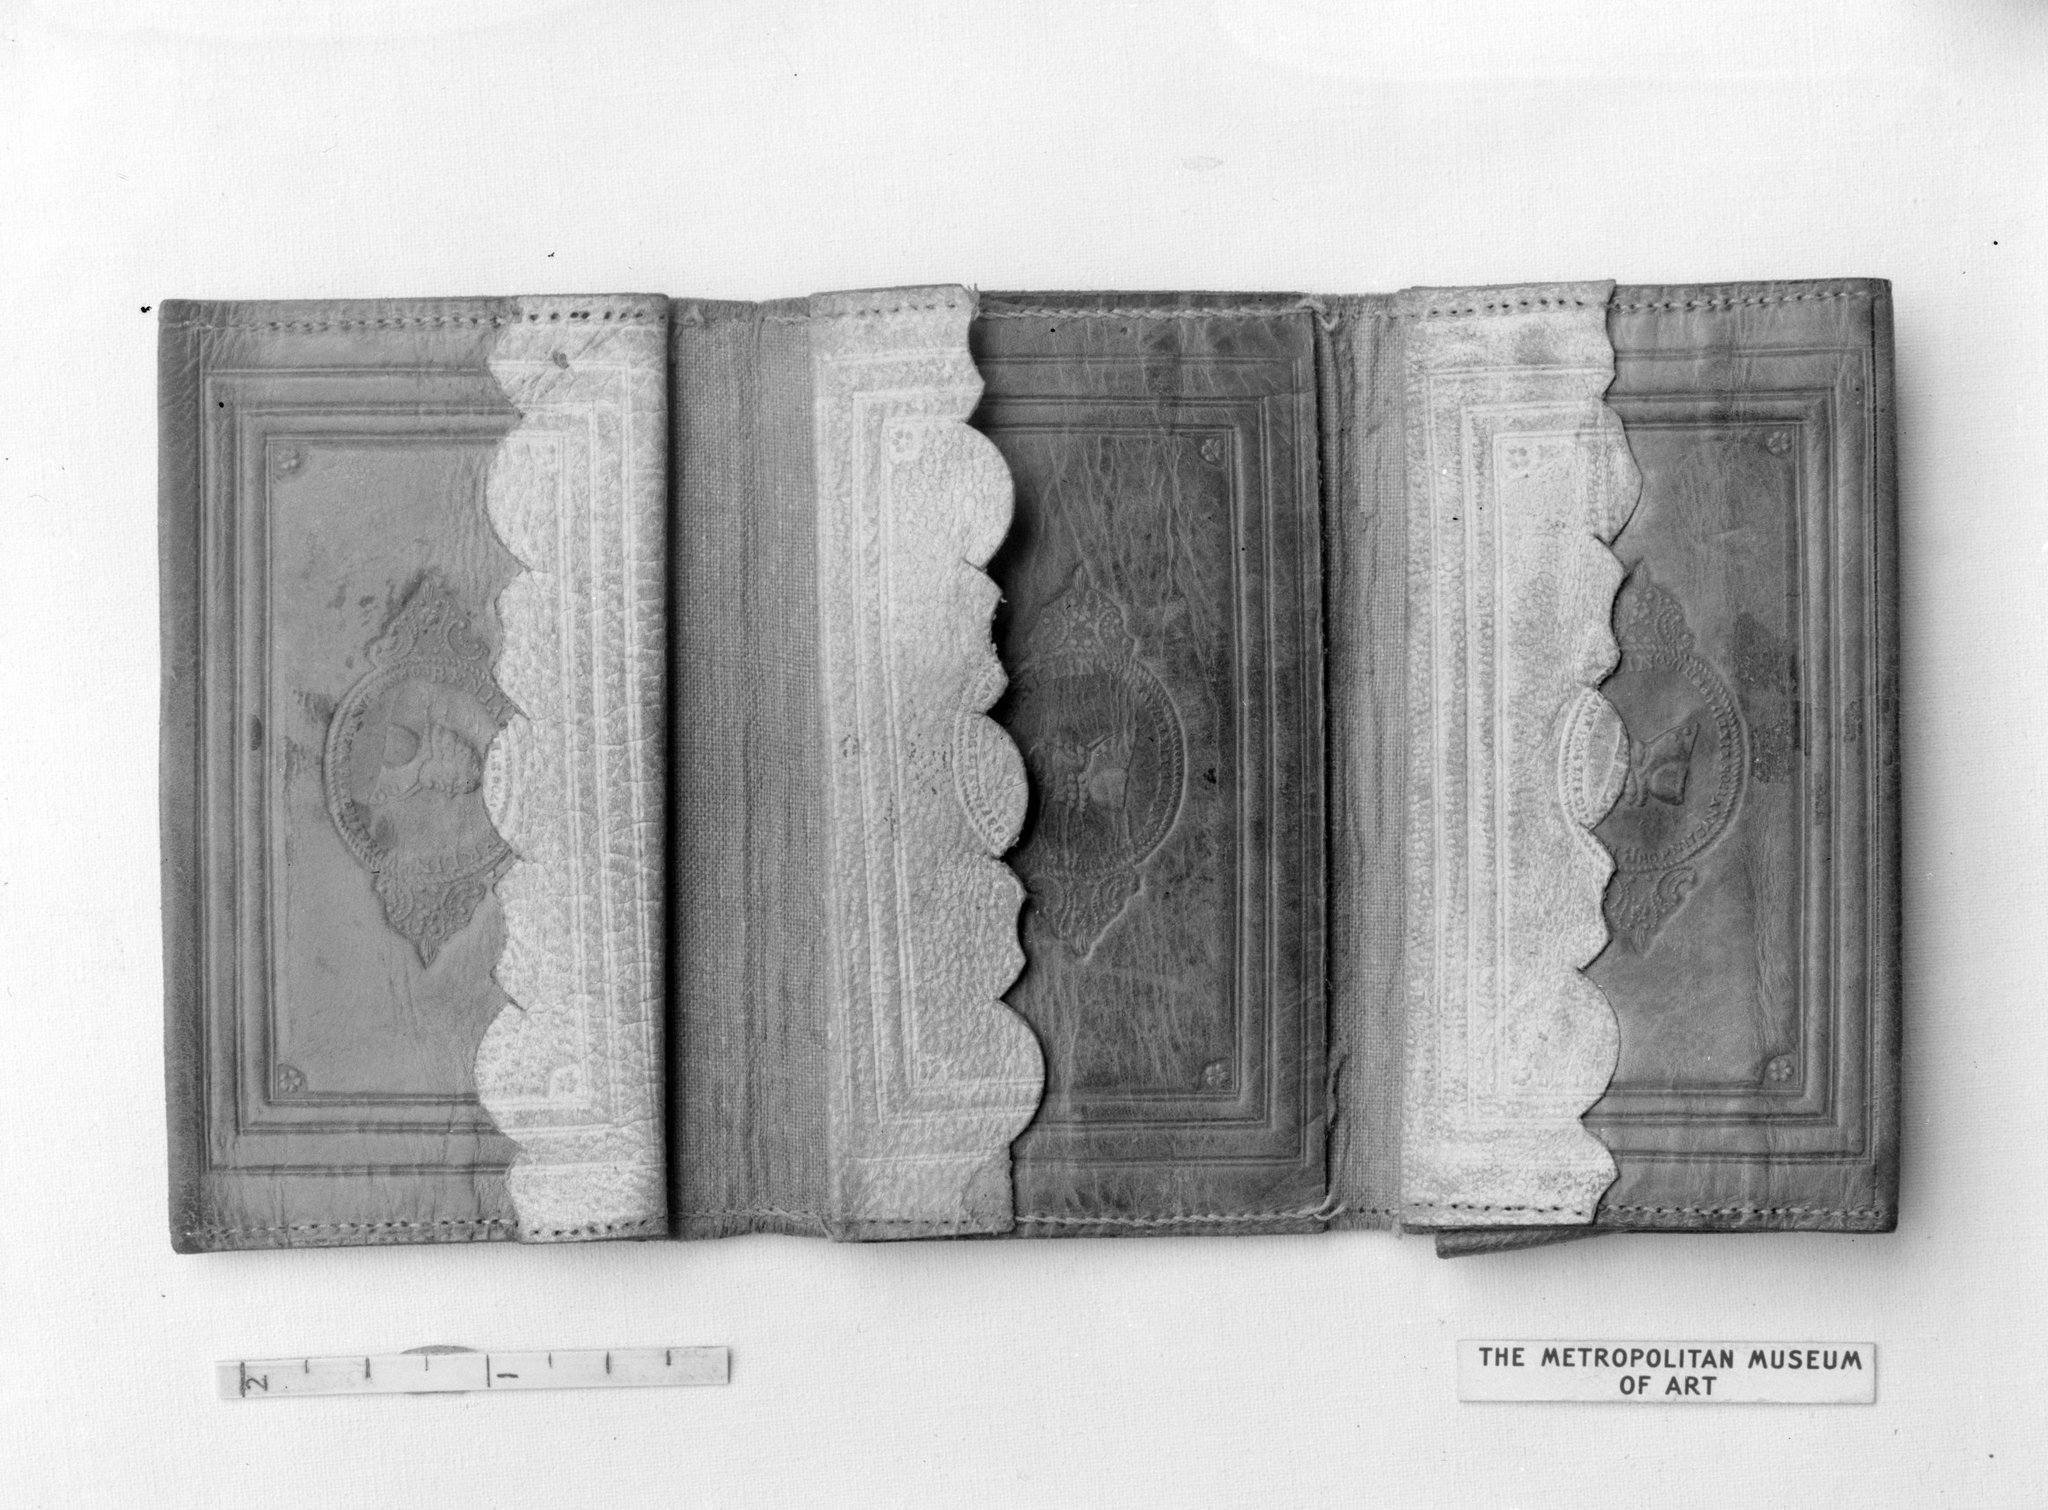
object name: pocketbook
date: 1790-1800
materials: leather